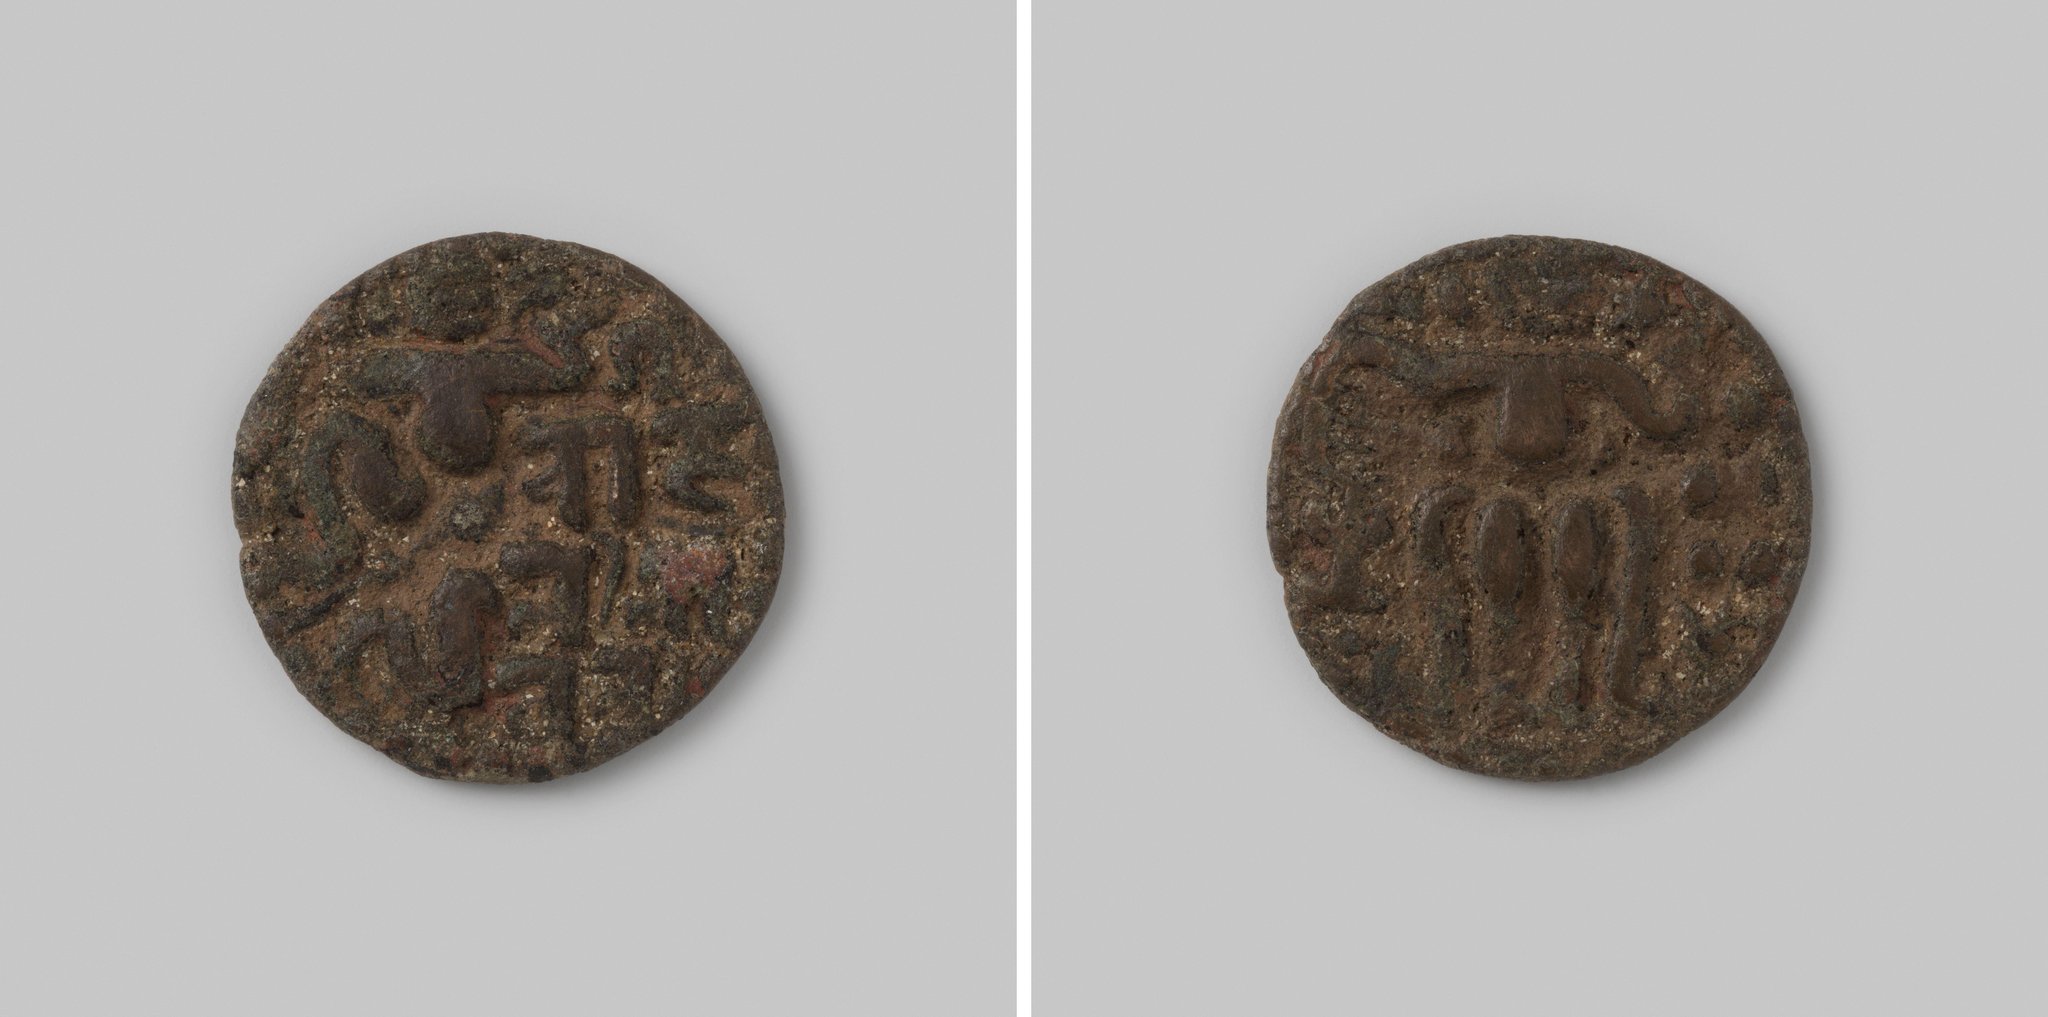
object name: coin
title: Kahavanu uit Sri Lanka, Ceylon van Raja Lilavati, 1197-1220, 1209-1211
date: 1197-1211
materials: copper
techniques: striking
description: Koperen munt. Voorzijde: zittende figuur, waaromheen in vier regels opschrift in Nagari-tekens: Sri/Raja/Lila/vati. Keerzijde: staande figuur, waaromheen symbolen.